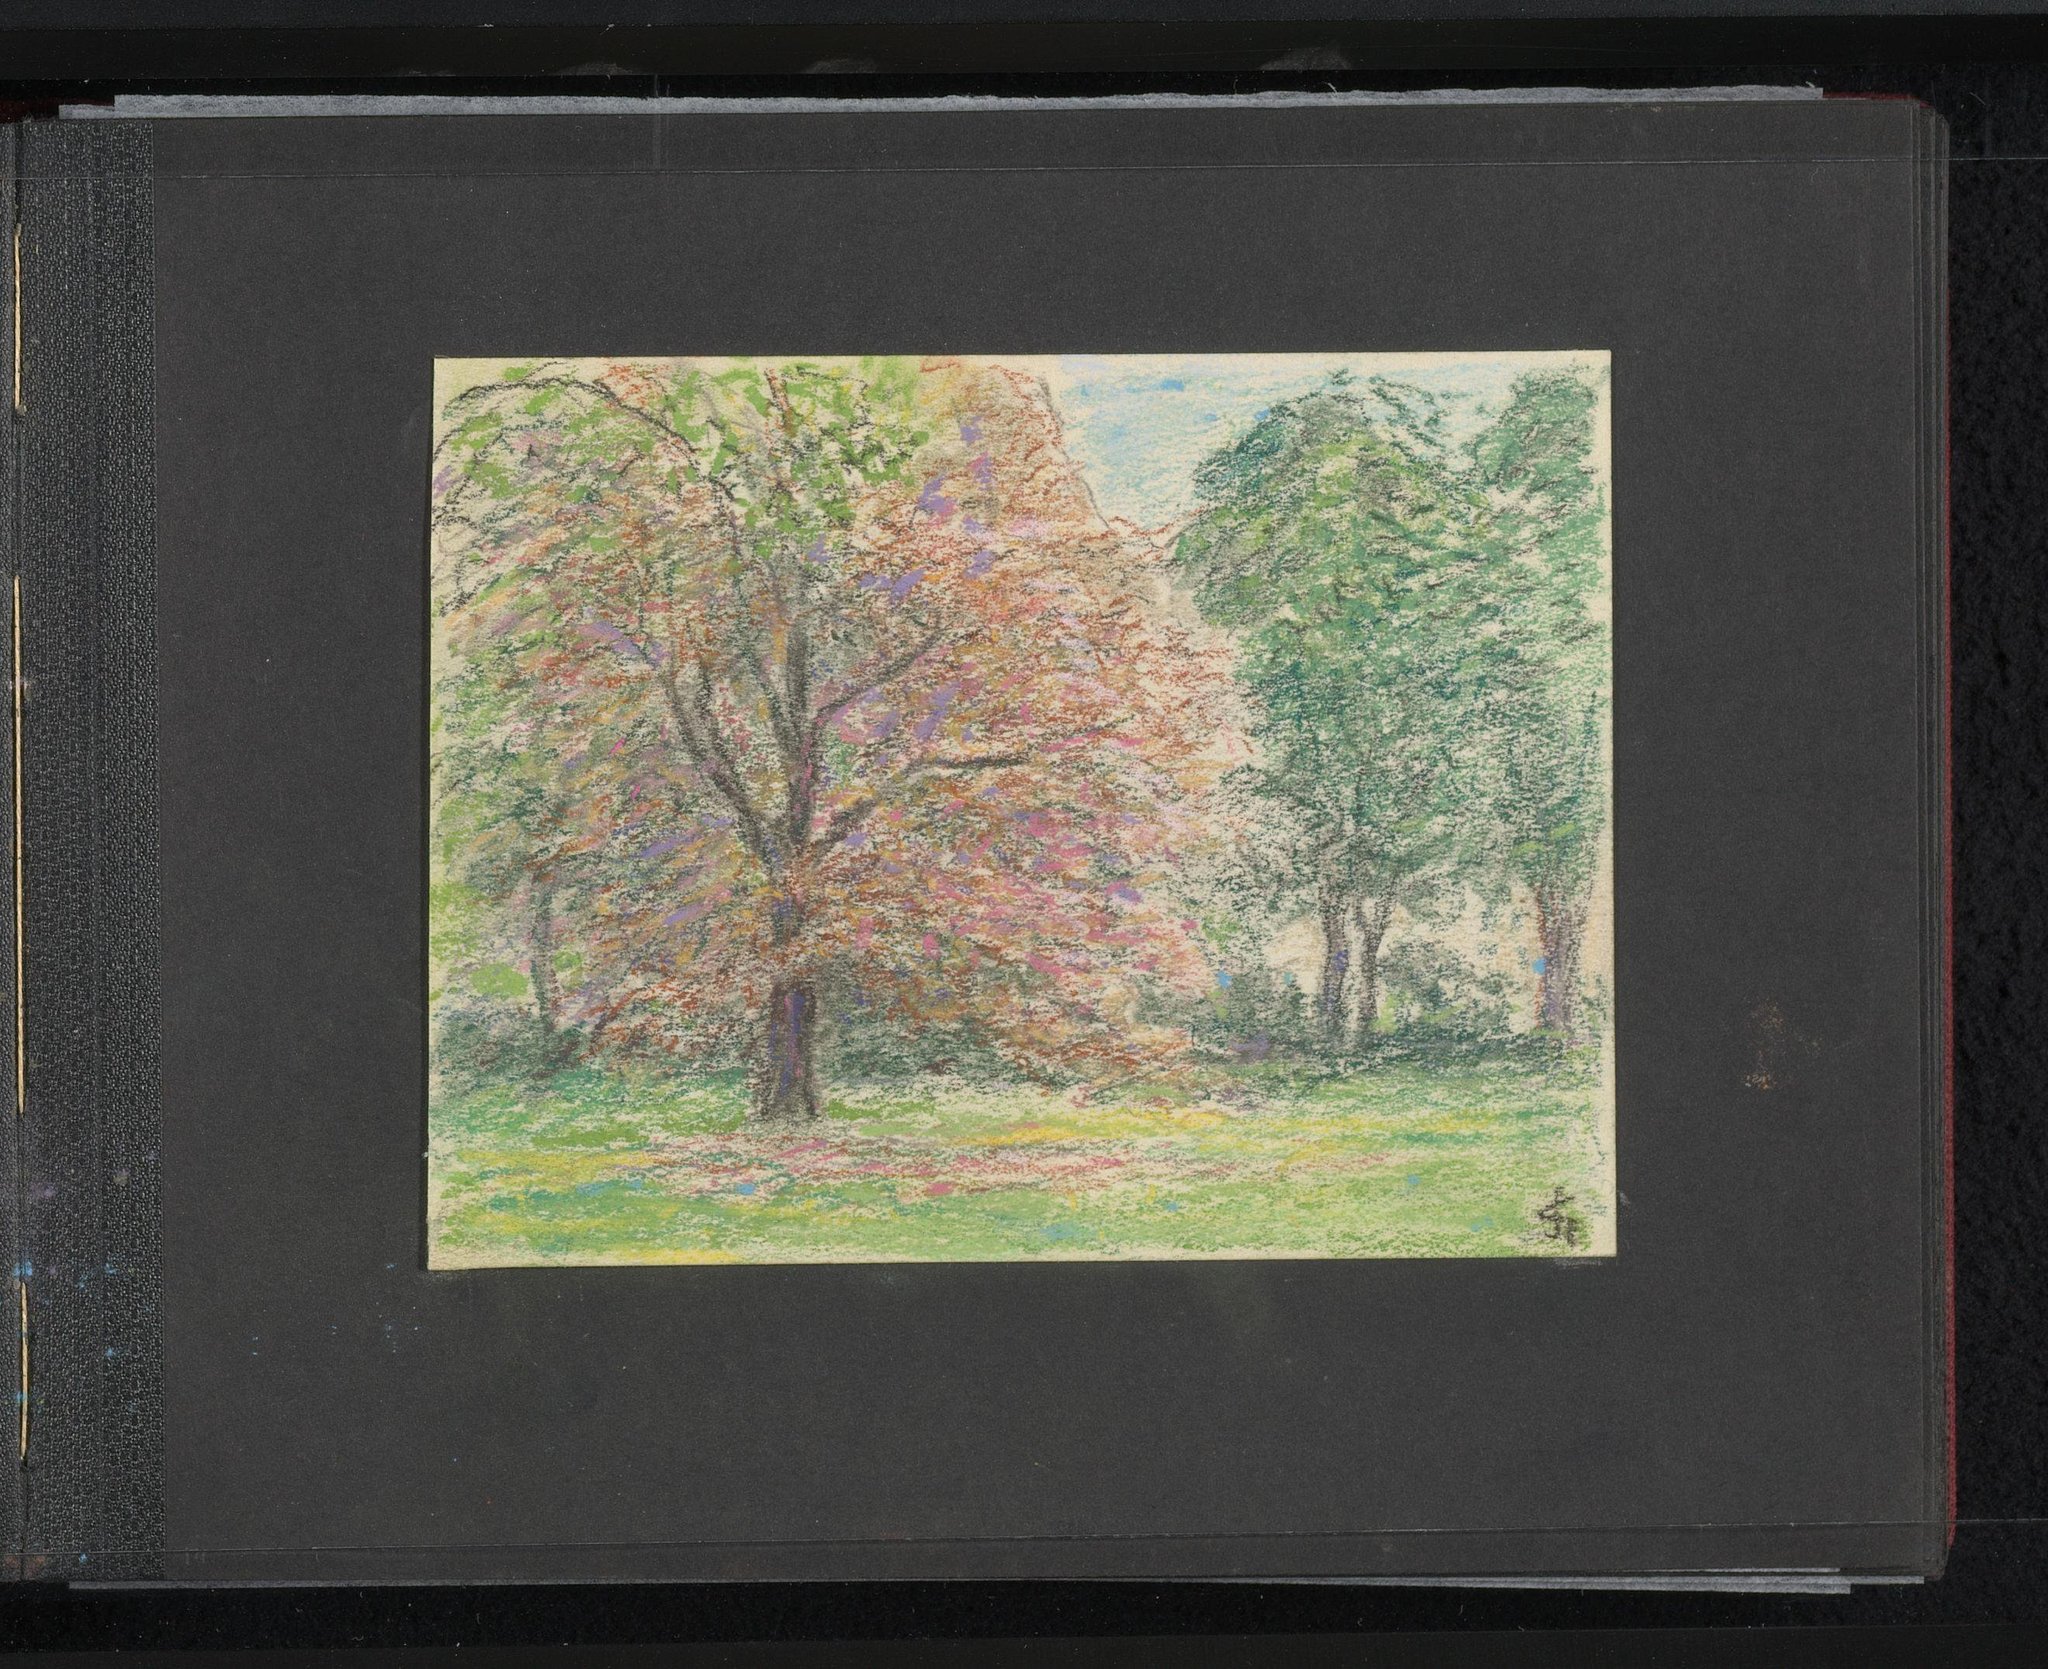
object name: drawing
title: Bomen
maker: carel nicolaas storm van s-gravesande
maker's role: draughtsman, print maker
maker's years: 1841-1924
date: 1915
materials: chalk, paper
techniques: pasting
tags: trees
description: Mogelijk te Wiesbaden. Tekening maakt deel uit van een album.